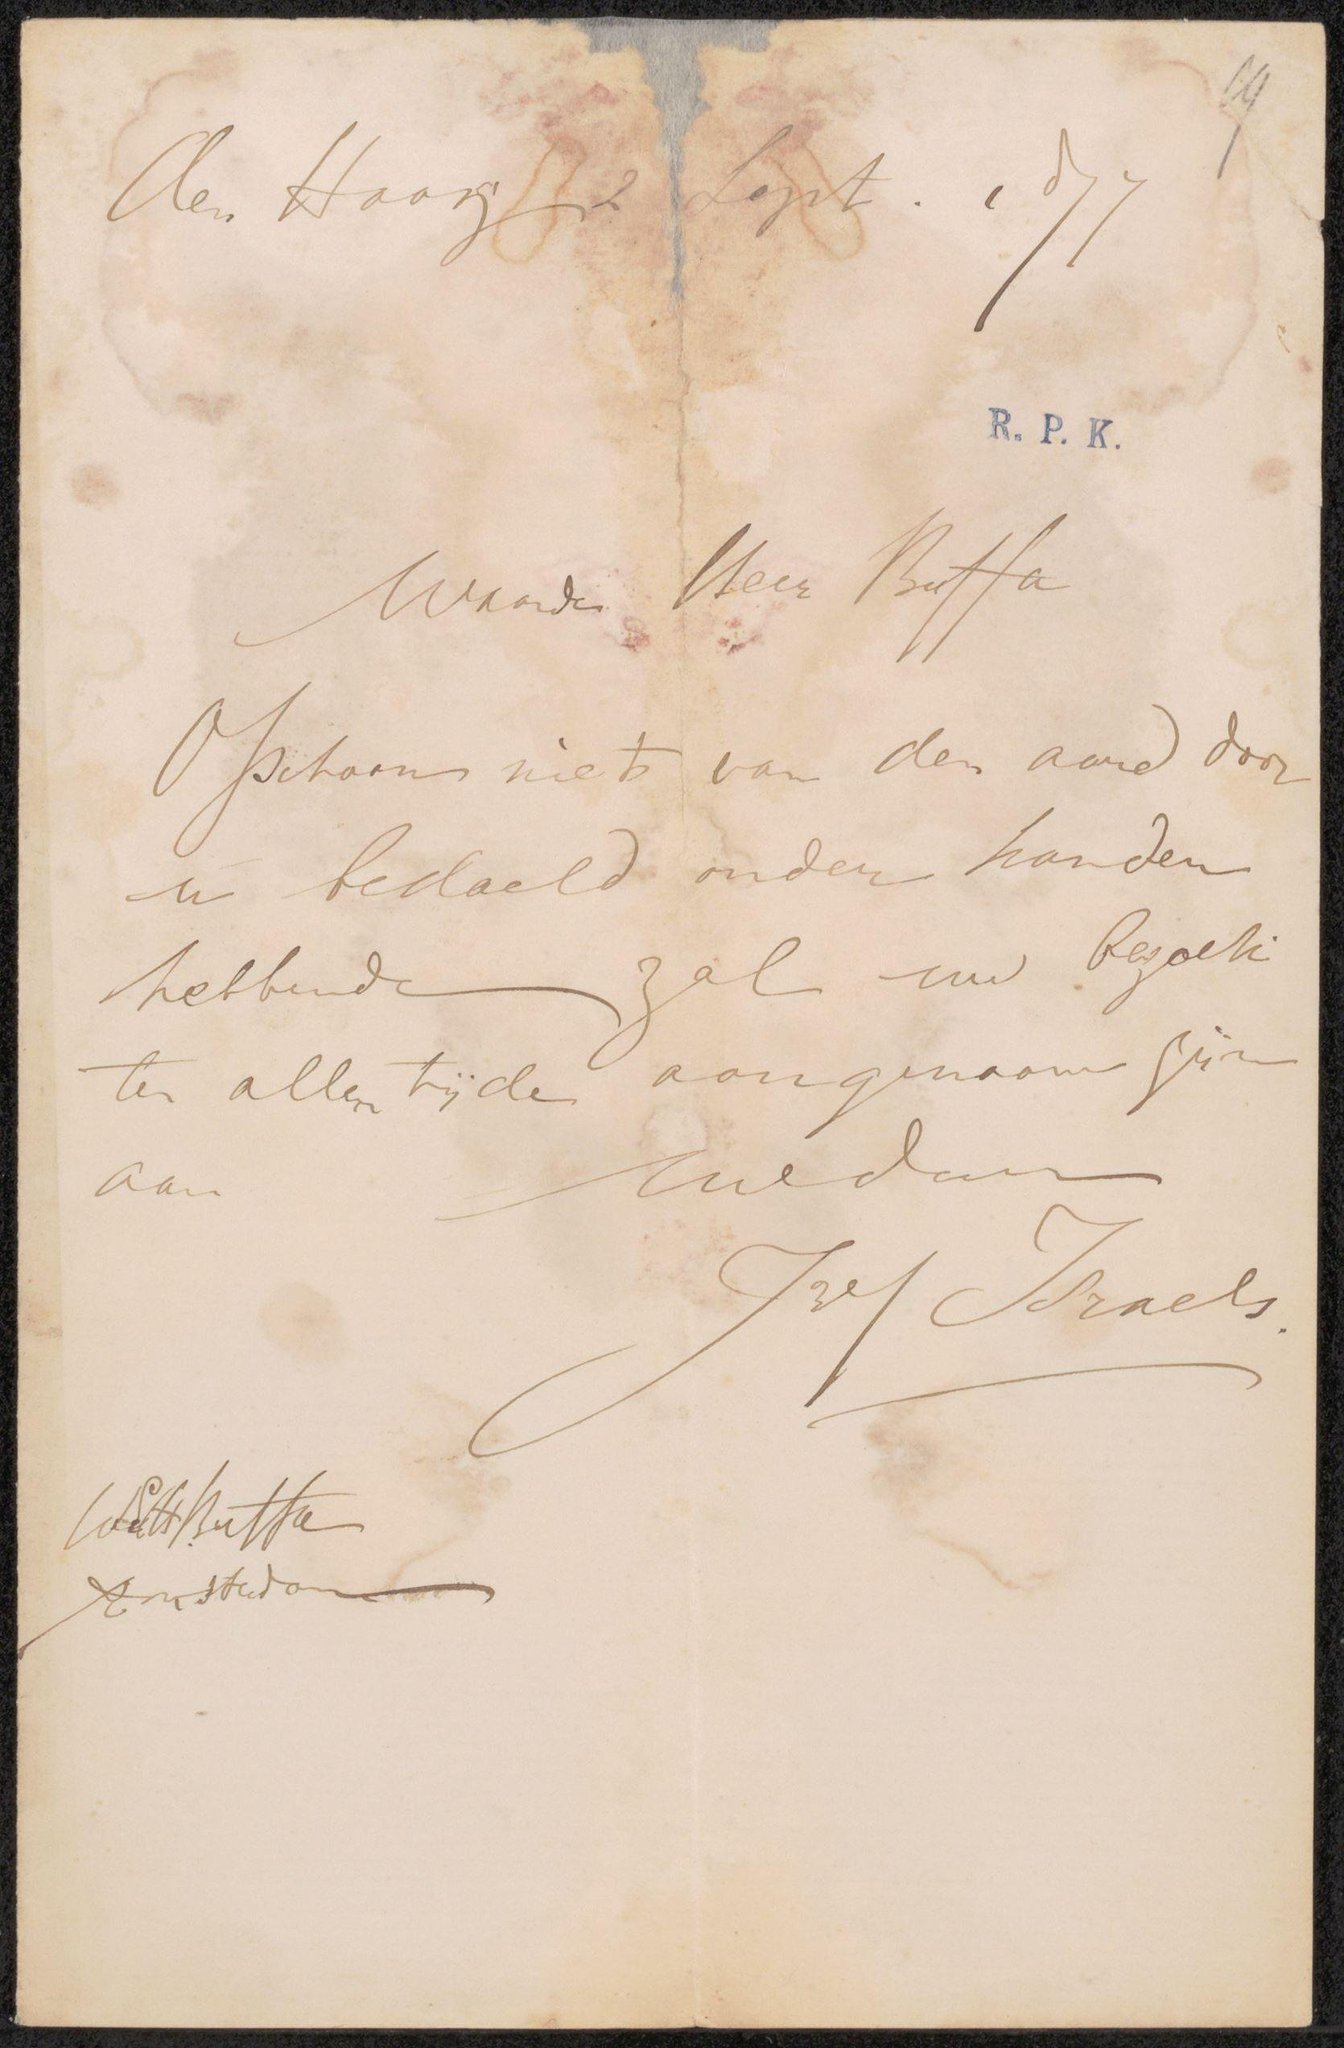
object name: letter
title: Brief aan Frans Buffa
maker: jozef israëls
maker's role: draughtsman, painter, print maker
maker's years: 1824-1911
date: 1877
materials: ink, paper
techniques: pen, writing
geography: the hague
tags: printer, publisher, frans buffa, amsterdam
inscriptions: collector's mark: Lugt 2233